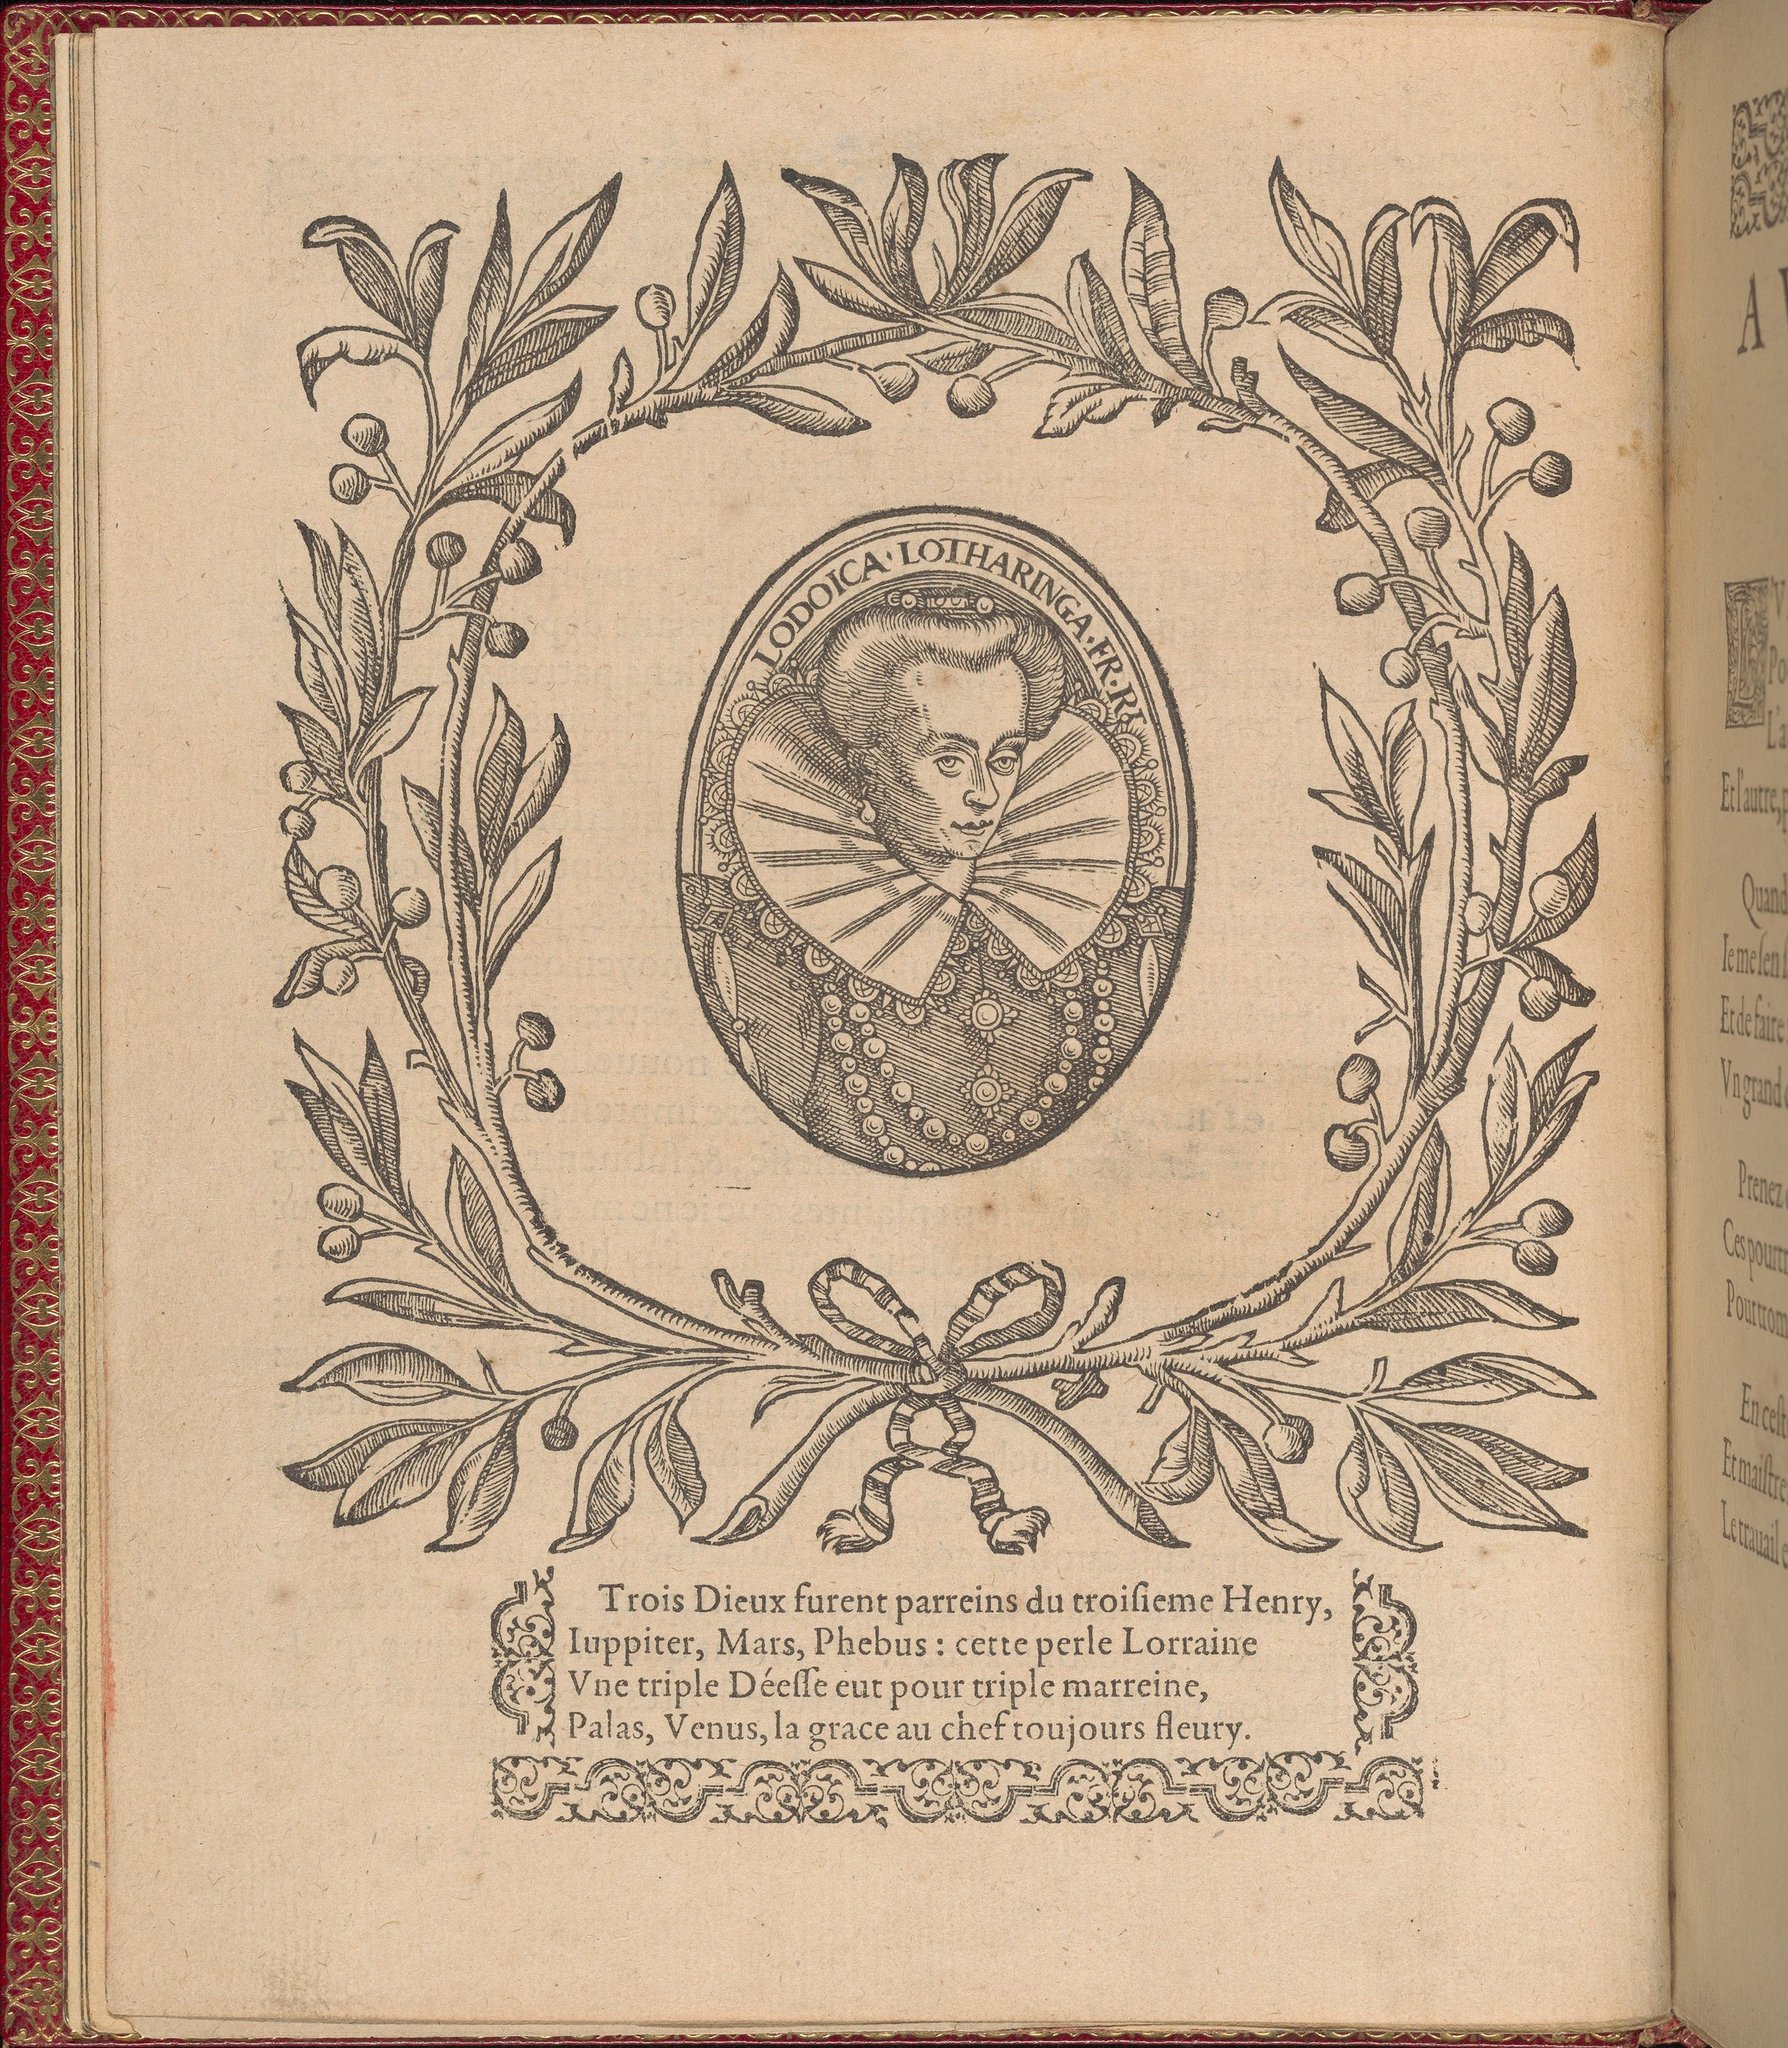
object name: book print ornament architecture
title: Les Singuliers et Nouveaux Portraicts... page 2 (verso)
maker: federico de vinciolo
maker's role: designer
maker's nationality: italian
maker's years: 1582-1599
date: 1588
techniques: woodcut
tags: portraits,women